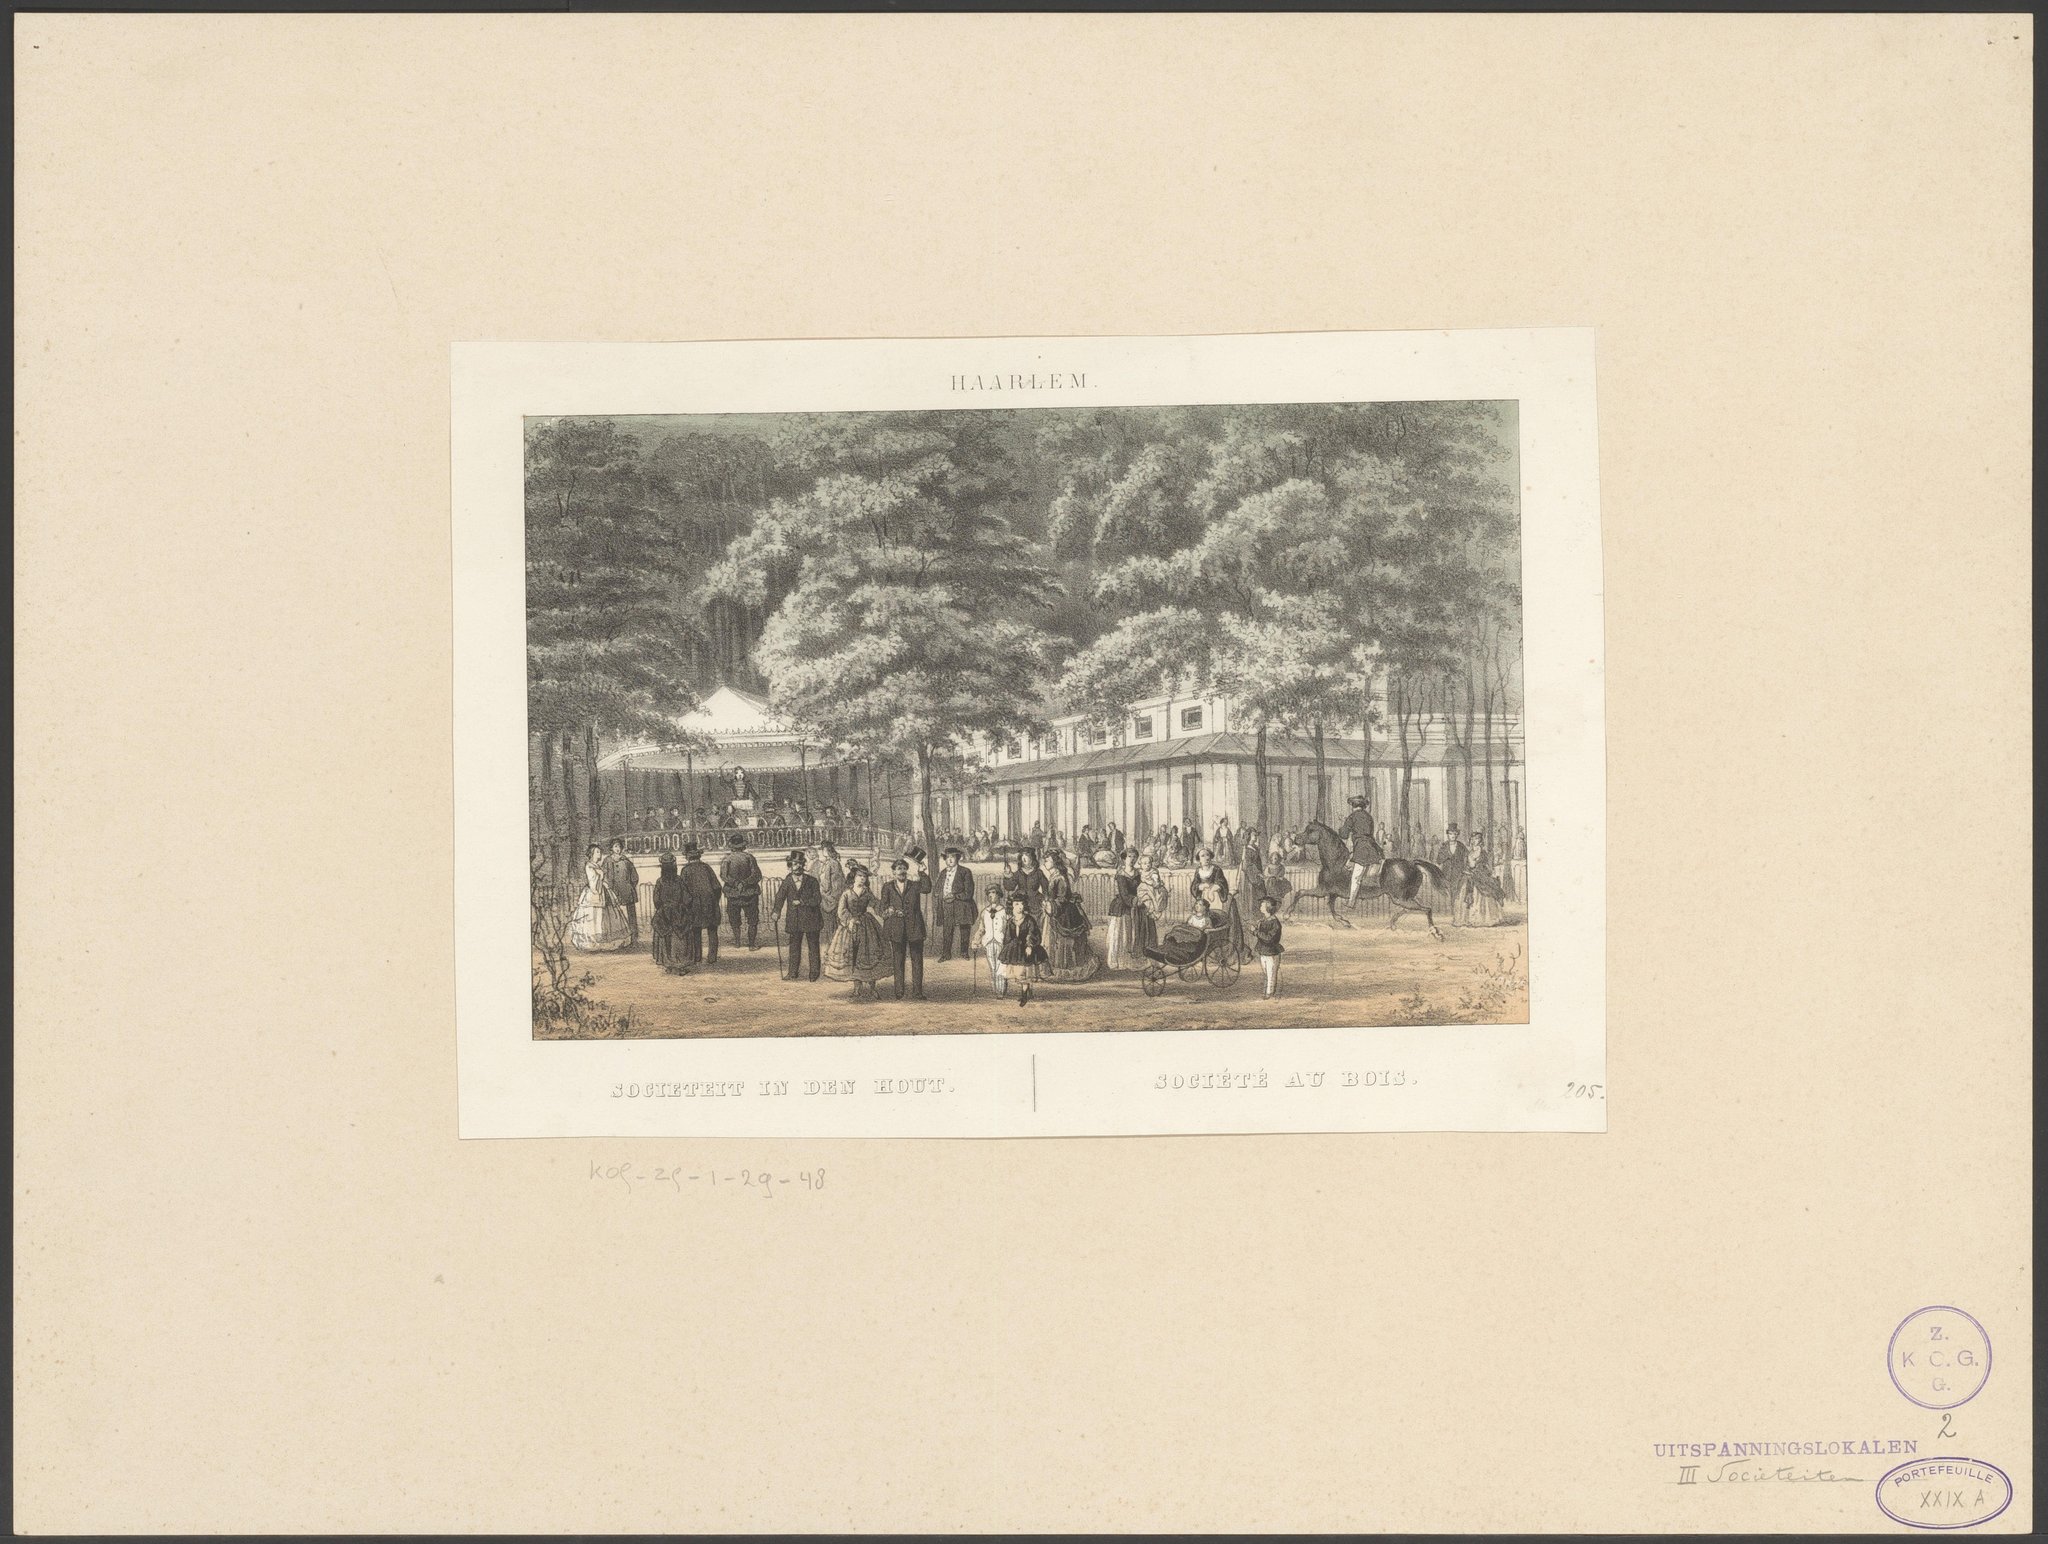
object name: print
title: Gezicht op de sociëteit in de Haarlemmerhout in Haarlem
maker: Anonymous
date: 1850-1899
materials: paper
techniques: iris print, lithograph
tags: baby-carriage, pram, perambulator, park, bandstand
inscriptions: stamp, collector's mark: Lugt 1641, stamp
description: Onderwerpsrubrieken binnen de Atlas Zeden en Gewoonten: Zeden en gewoonten in engeren zin, Volksleven, Uitspanningslokalen, Societeiten.